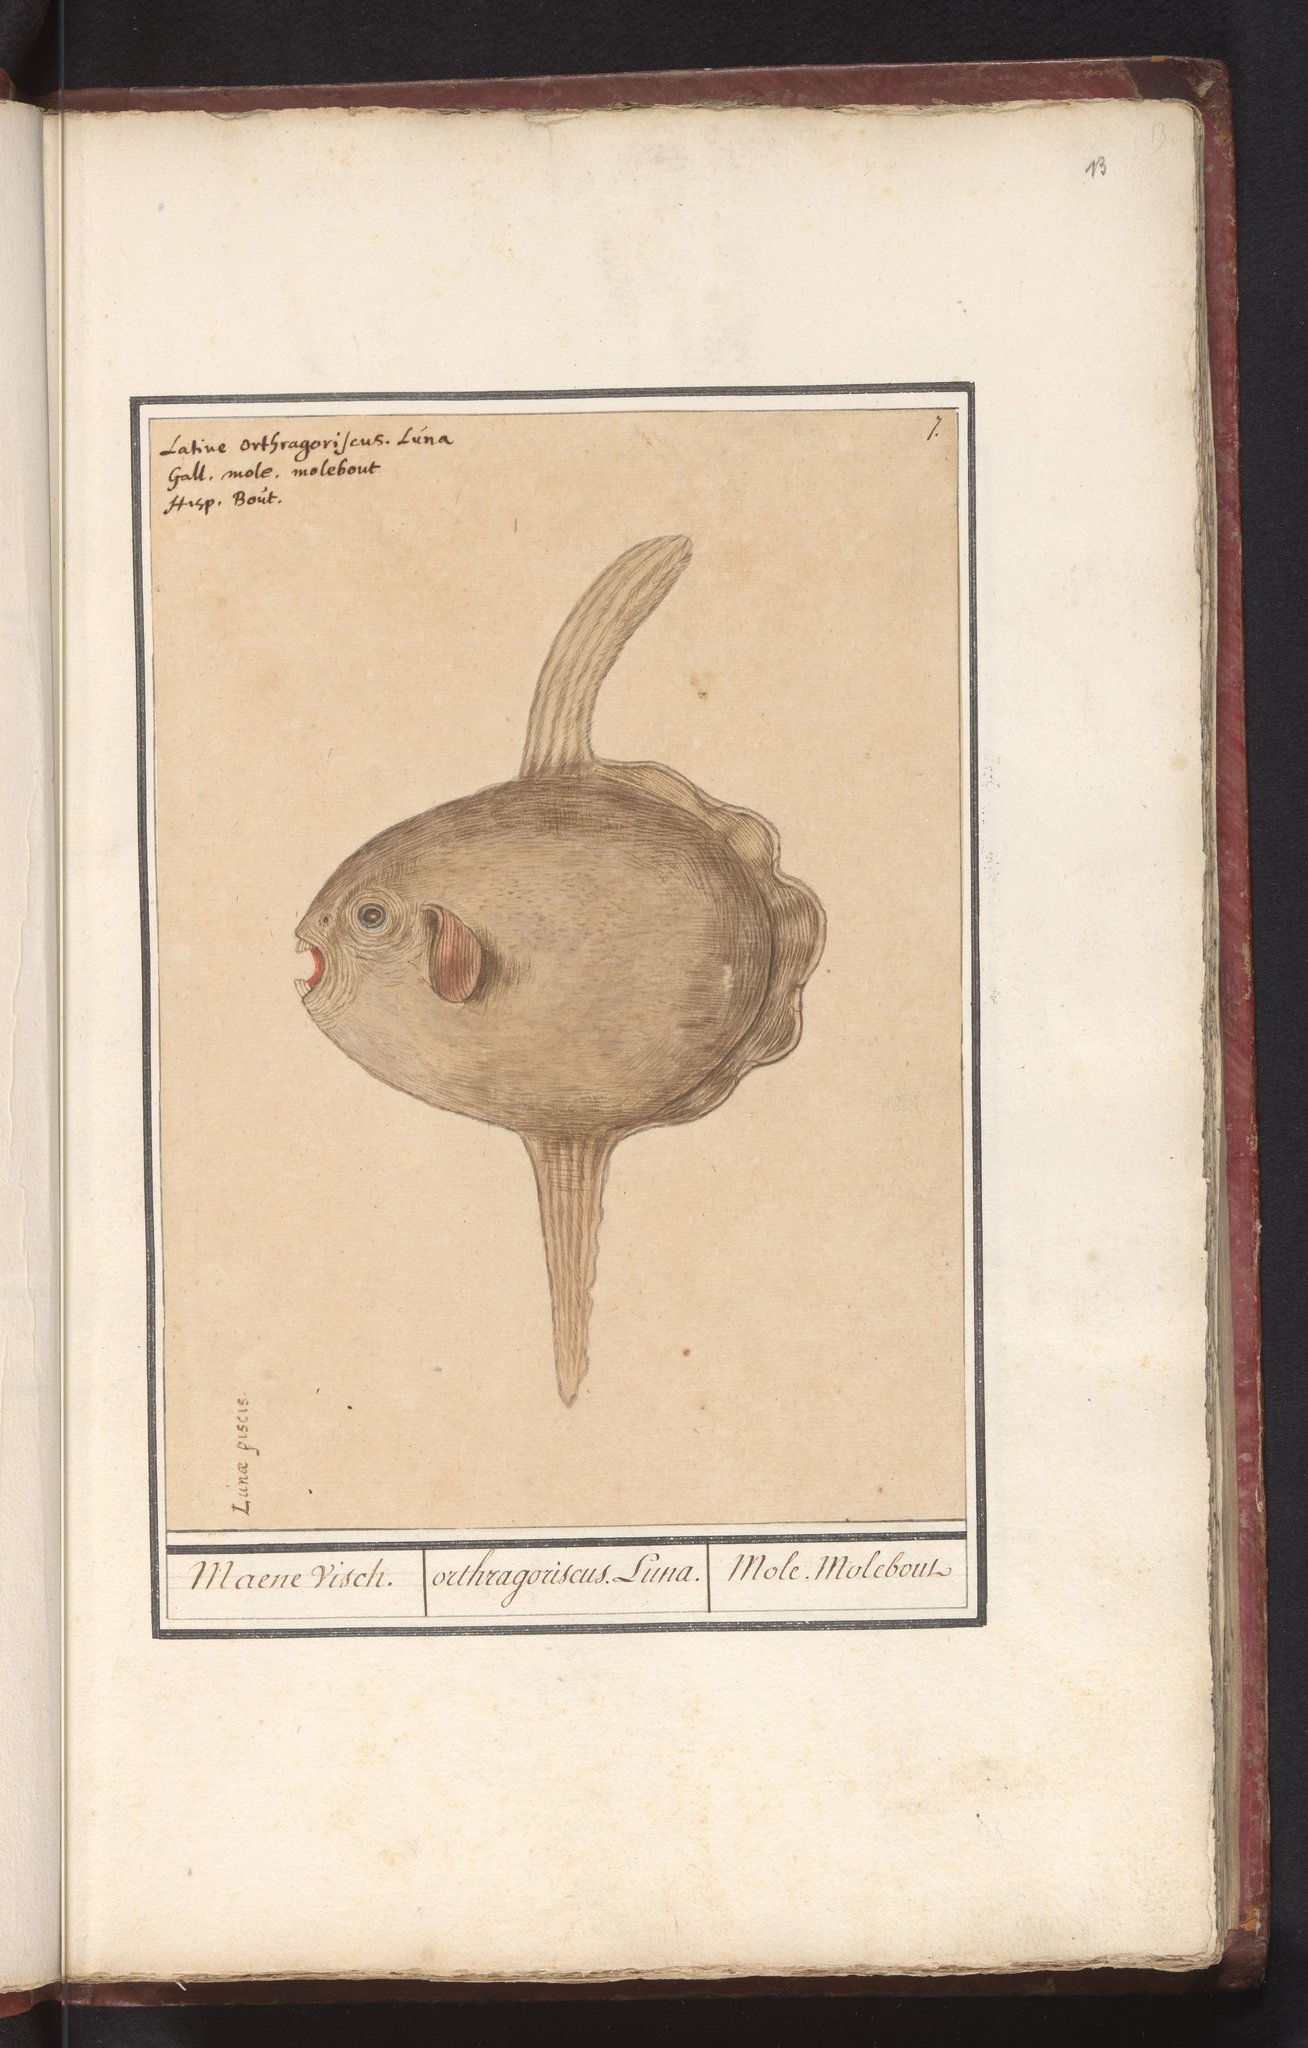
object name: drawing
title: Ocean Sunfish (Mola Mola)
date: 1596-1610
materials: chalk, paint, ink, paper, pencil, watercolor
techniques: brush, pen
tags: bony fishes: ocean sunfish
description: The ocean sunfish owes its Latin name Mola, meaning millstone, to its leathery and rough skin. The Dutch name Maanvis, or moonfish, derives from the resemblance between its shape and the celestial body. De Boodt might have seen a stuffed specimen in Emperor Rudolf II’s cabinet of curiosities. Just how large that moonfish was is not clear in this drawing: they can reach a size of 4 metres.